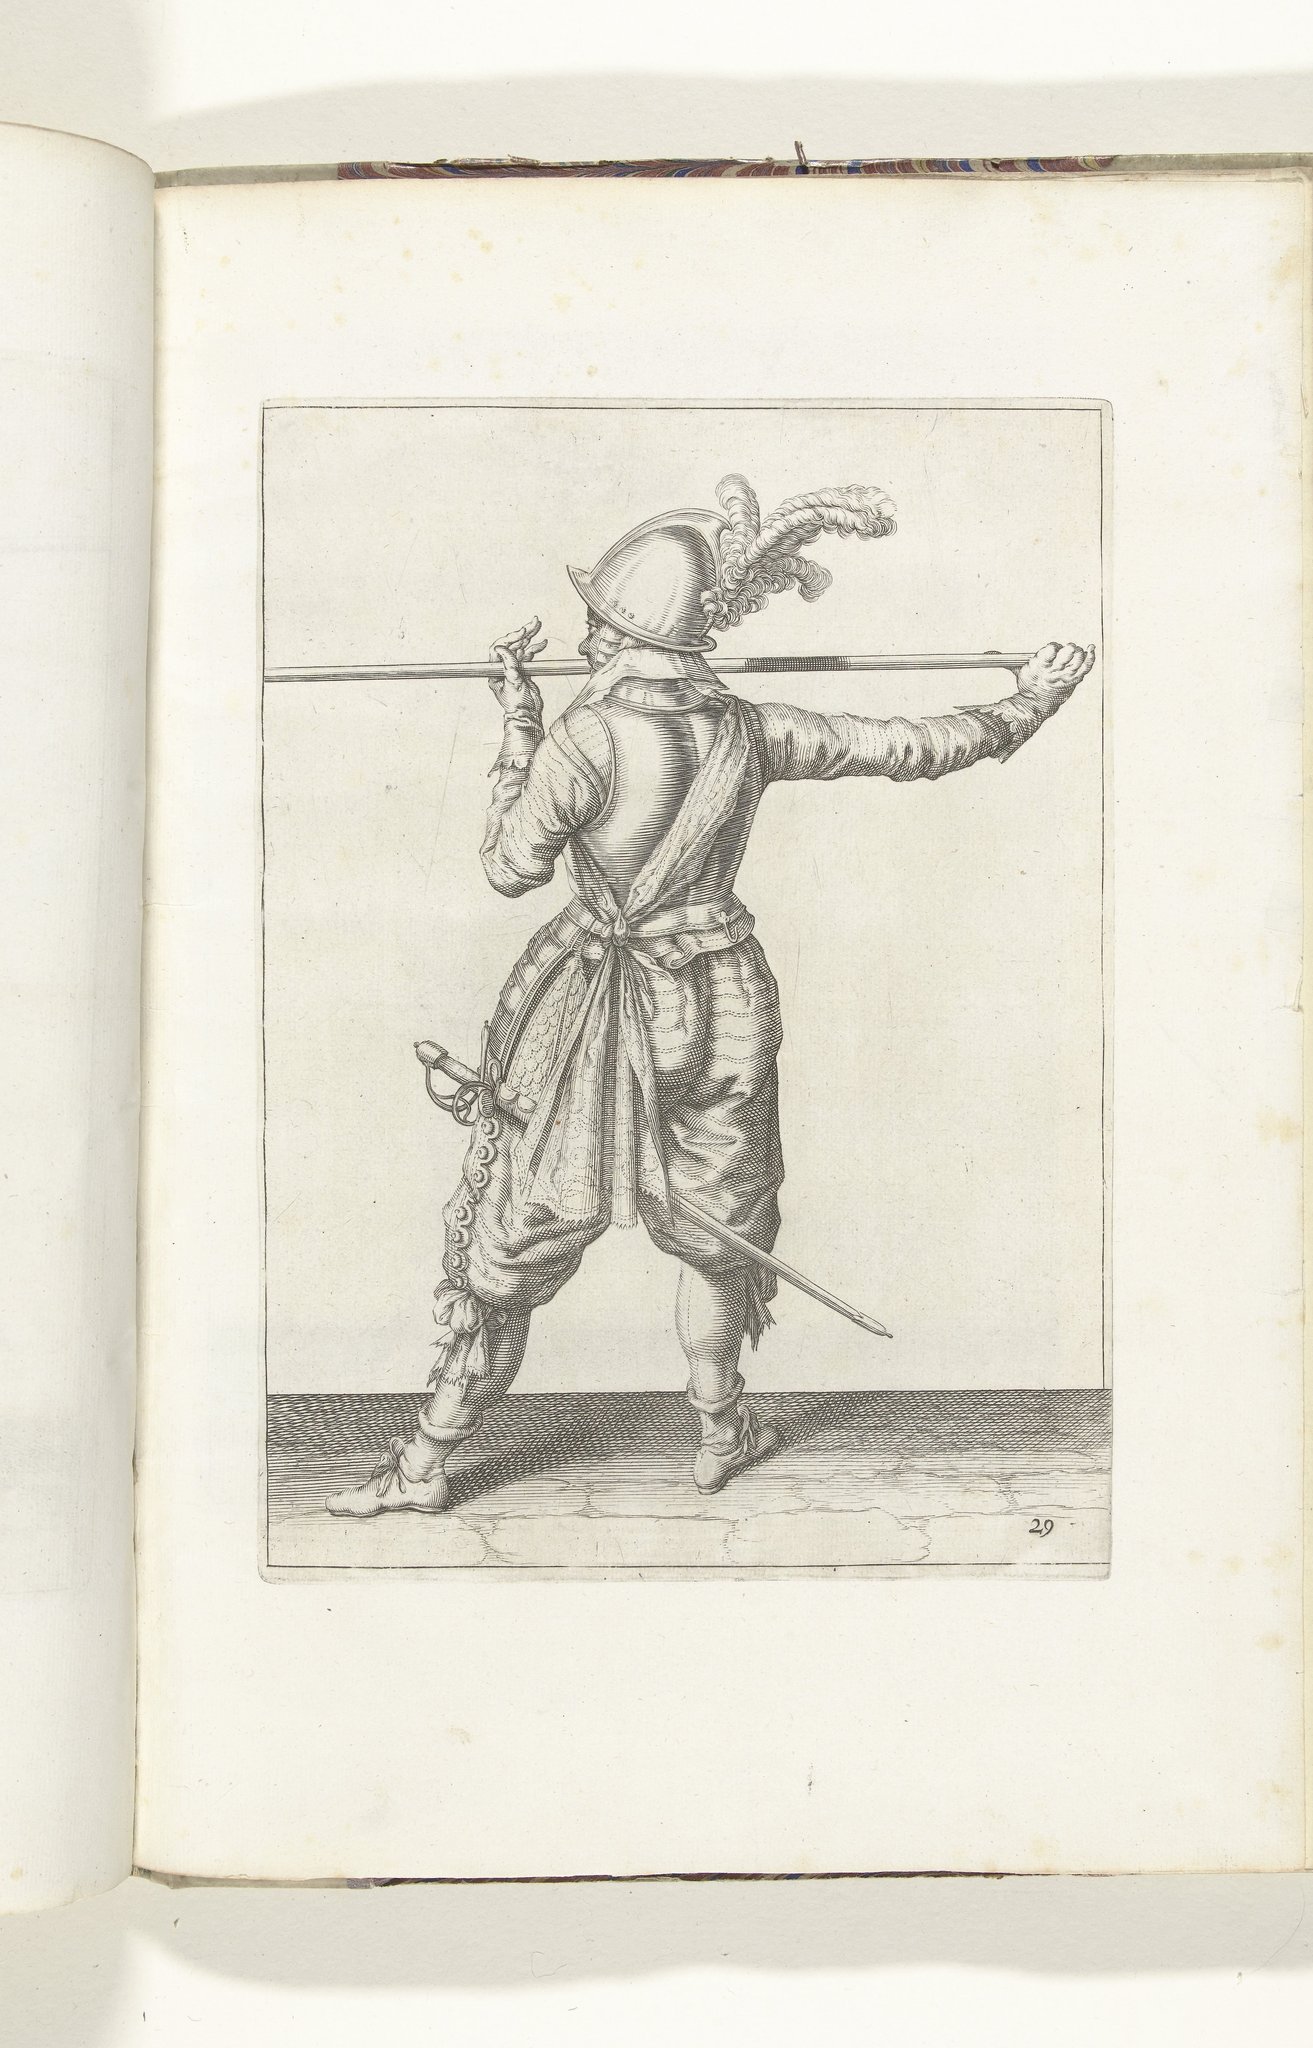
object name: print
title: Soldaat, op de rug gezien, die zijn spies met beide handen horizontaal op neushoogte draagt, zijn rechterhand bij de voet van het wapen, zijn gezicht naar links gewend (nr. 29), ca. 1600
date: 1597-1607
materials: paper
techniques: engraving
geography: amsterdam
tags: maurice (prince of orange), handling of weapons ~ military training, weapons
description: Een soldaat, ten voeten uit, op de rug gezien, die een spies (lans) met beide handen horizontaal op neushoogte draagt, zijn rechterhand bij de voet van het wapen, zijn gezicht naar links gewend (nr. 29), ca. 1600. Plaat 29 in de instructies voor het hanteren van de spies: Corte onderwysinghe op de figuerliicke afbeeldinghe belanghende trechte gebruck, van alle t'ghene een Soldaet int handelen vande Spies noodich is. Onderdeel van de illustraties in: J. de Gheyn, Wapenhandelinghe van Roers Musquetten ende spiessen, Amsterdam, 1608. Krijgswezen rond 1600.